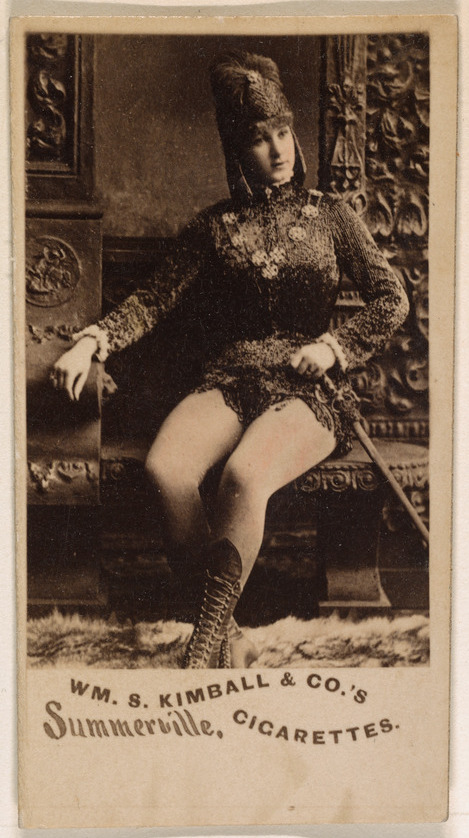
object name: photograph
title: Miss Summerville, from the Actresses series (N203) issued by Wm. S. Kimball & Co.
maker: william s. kimball & company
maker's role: publisher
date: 1889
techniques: color lithograph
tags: portraits,women,actresses